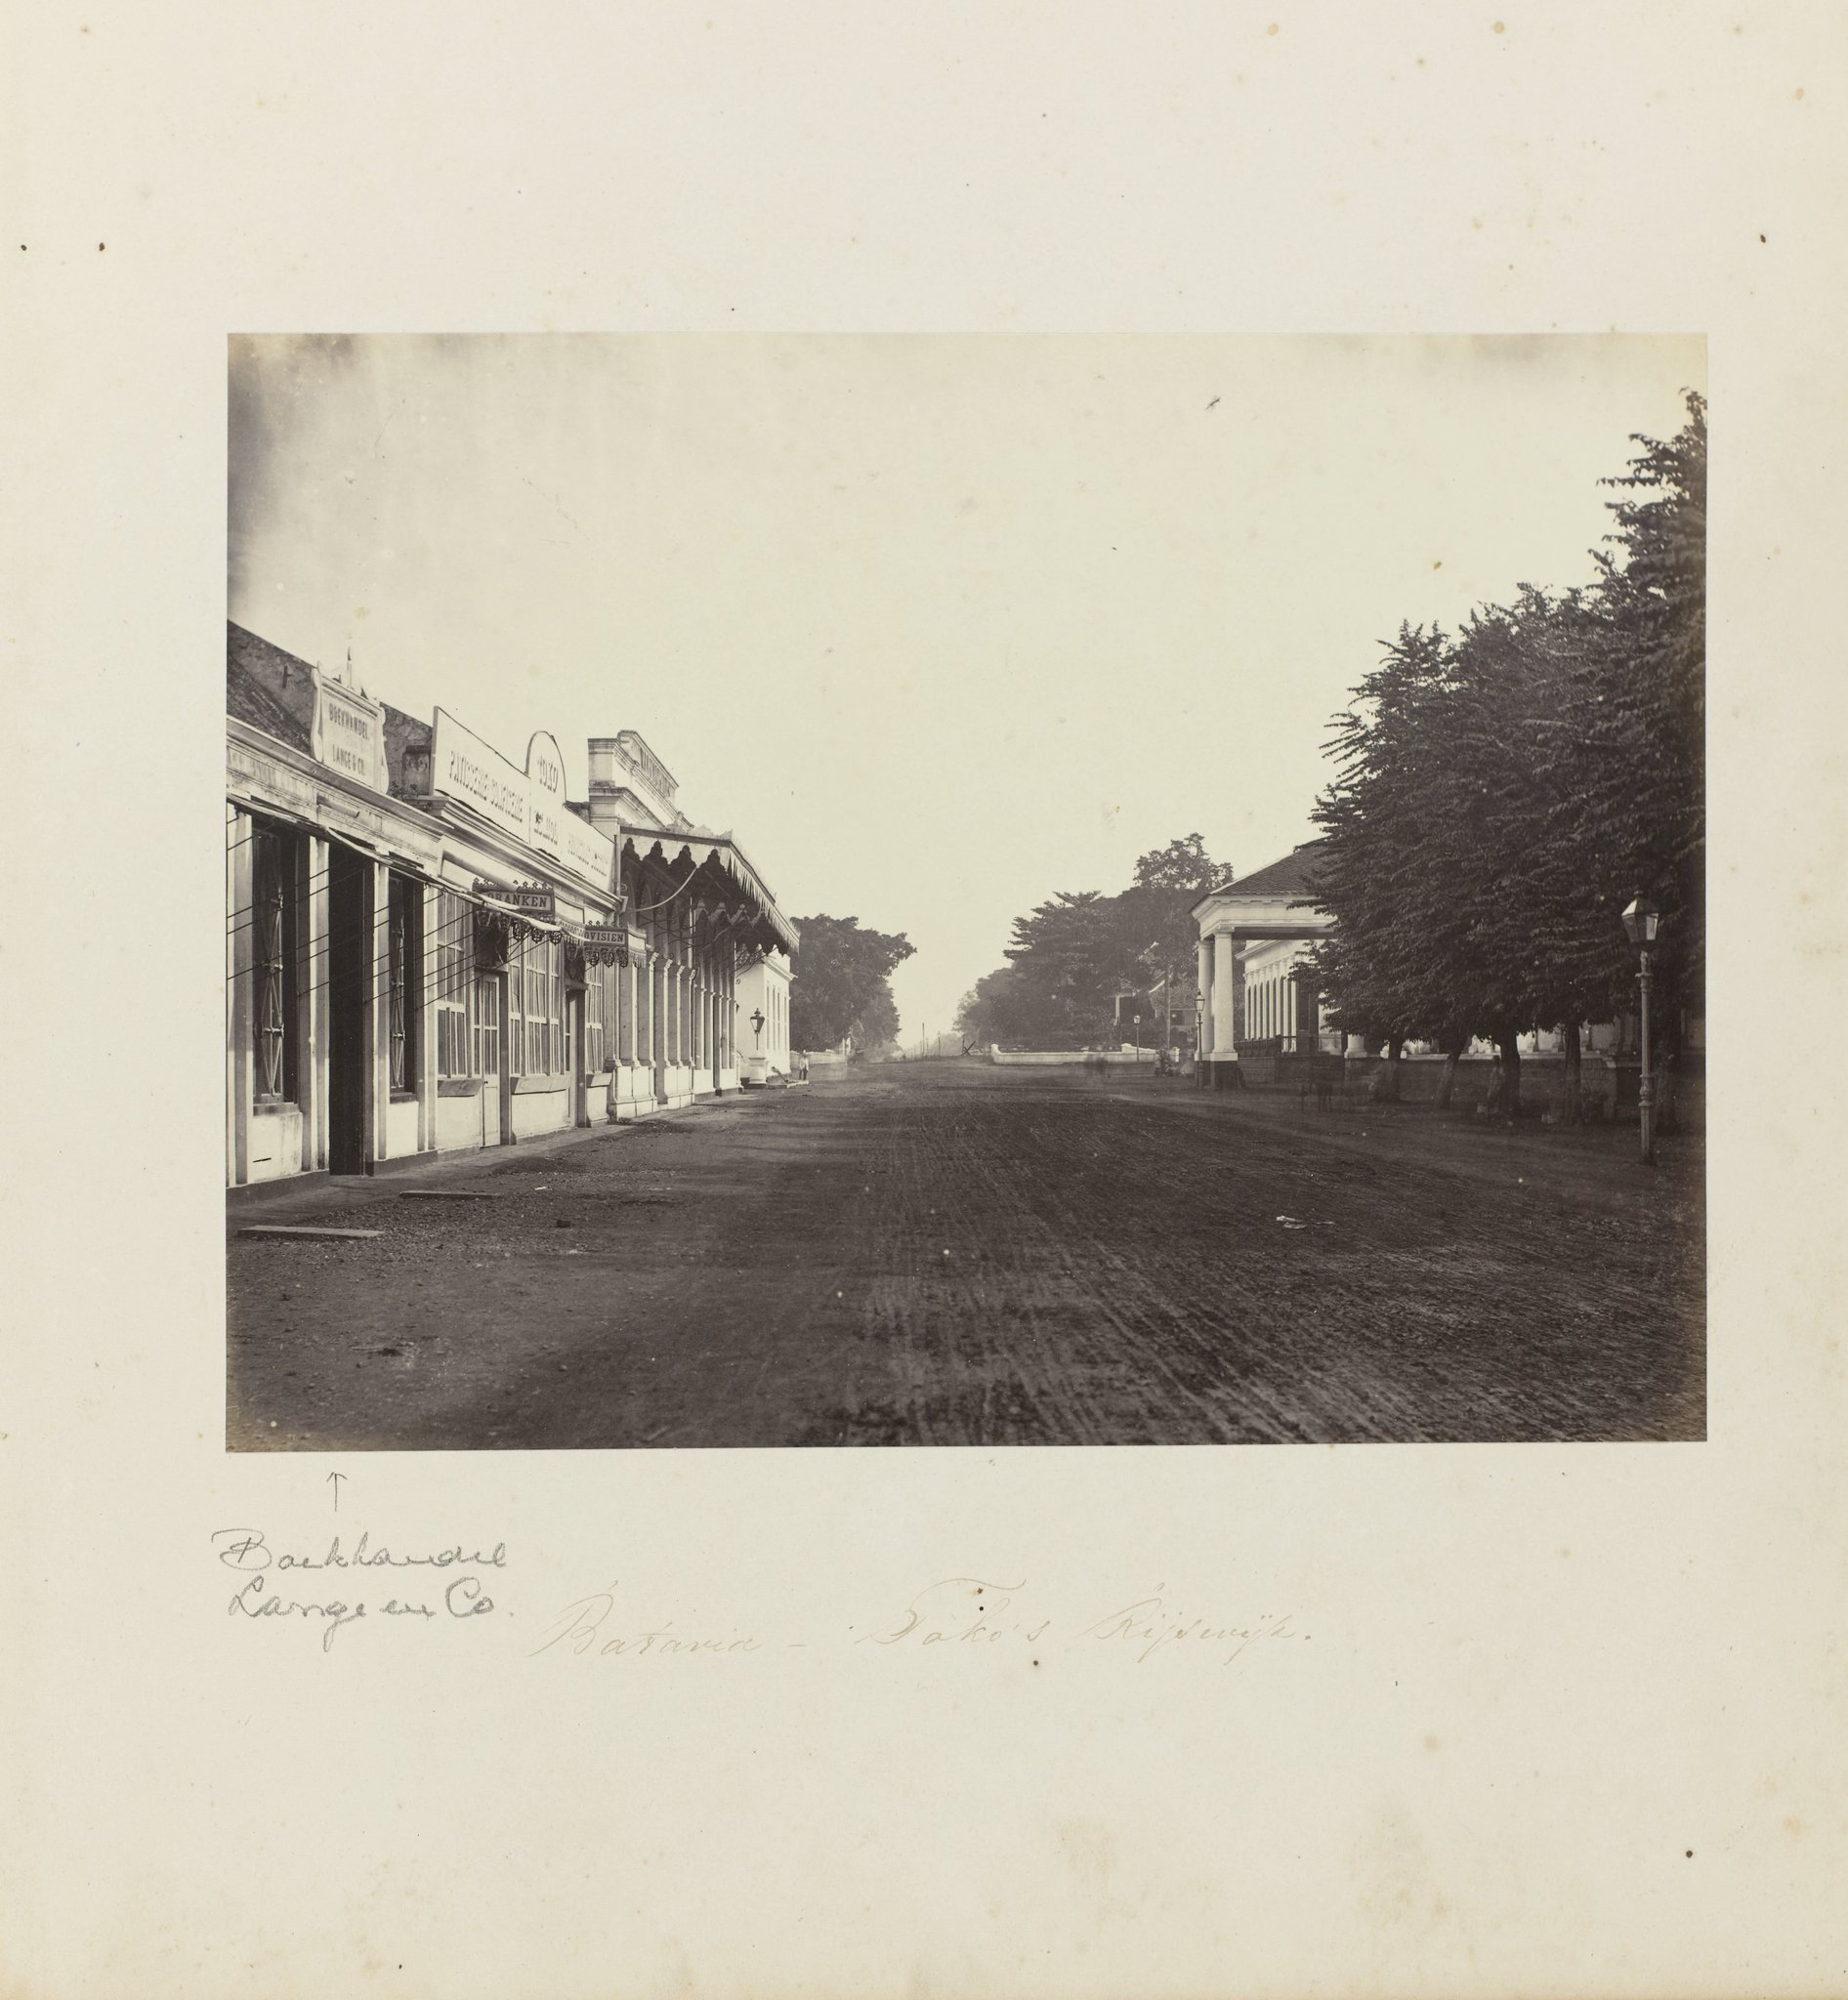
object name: photograph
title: Batavia - Toko's Rijswijk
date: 1863-1866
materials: photographic support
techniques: albumen print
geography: batavia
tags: shop, store, street, batavia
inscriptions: inscription: ‘Batavia - Toko's Rijswijk’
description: Winkelstraat in Rijswijk in Batavia, links de boekhandel Lange & Co., rechts sociëteit de Harmonie. Onderdeel van het rode fotoalbum met foto's van Java, uit het bezit van apotheker Specht-Grijp, die in 1865 vanuit Batavia naar Nederland terugkeerde.